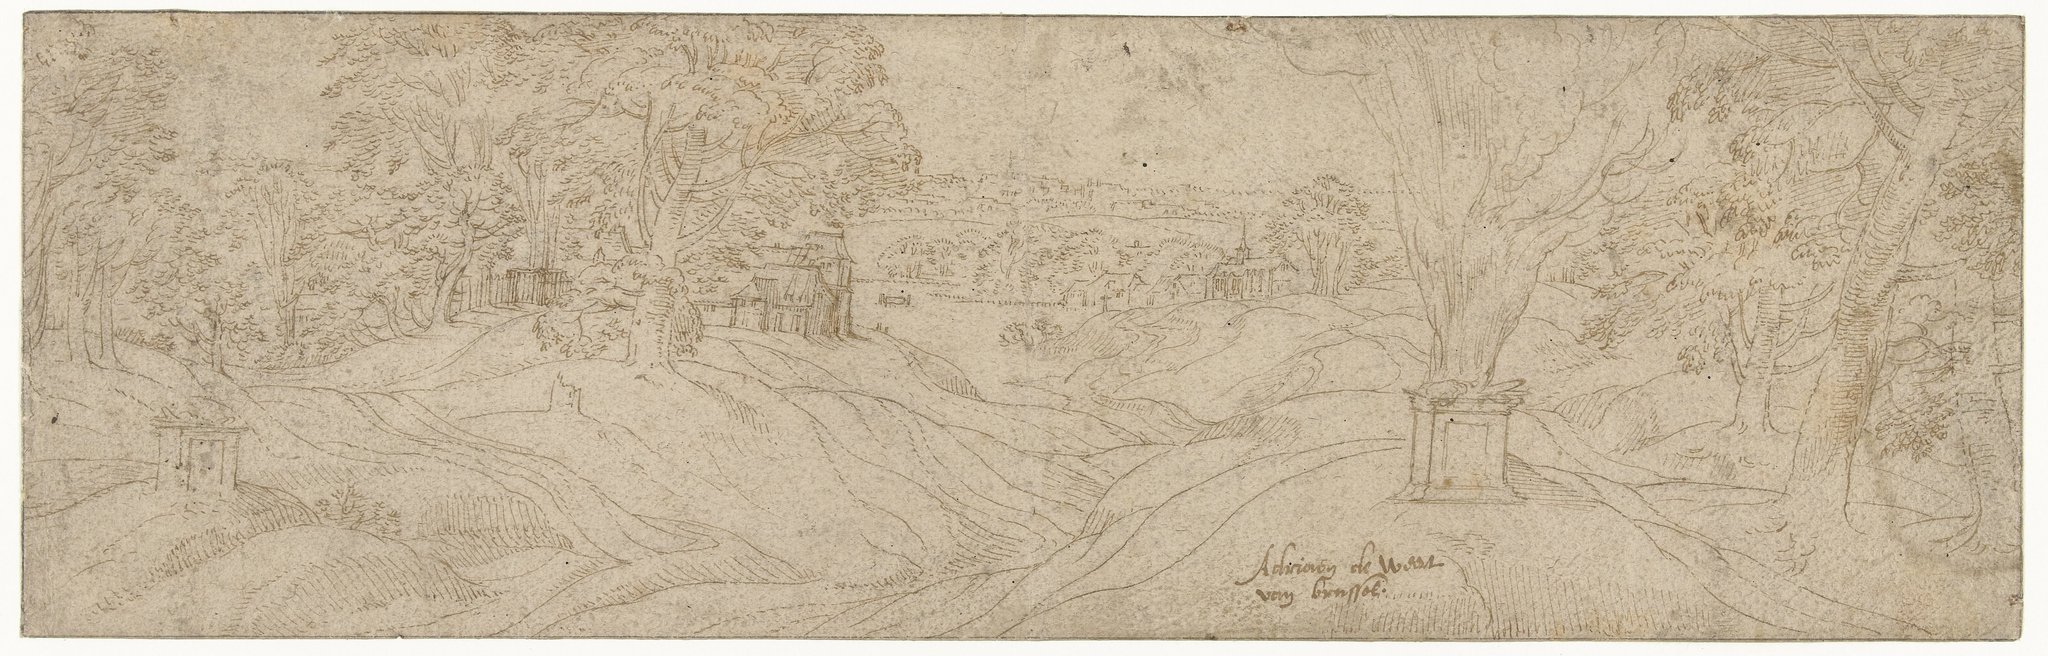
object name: drawing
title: Landscape with Two Altars or Beacons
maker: adriaan de weerdt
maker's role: draughtsman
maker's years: 1510-1590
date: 1510-1571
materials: chalk, ink, paper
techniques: pen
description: From contemporary sources, we know that De Weerdt was trained as a landscape painter. Yet this signed drawing is his only known work in that genre. Leafy trees flank the composition. In the middle, a winding path, drawn in undulating lines, leads towards a village. The path is marked on the left and right by beacons, from which flames and smoke billow, further enlivening the scene.